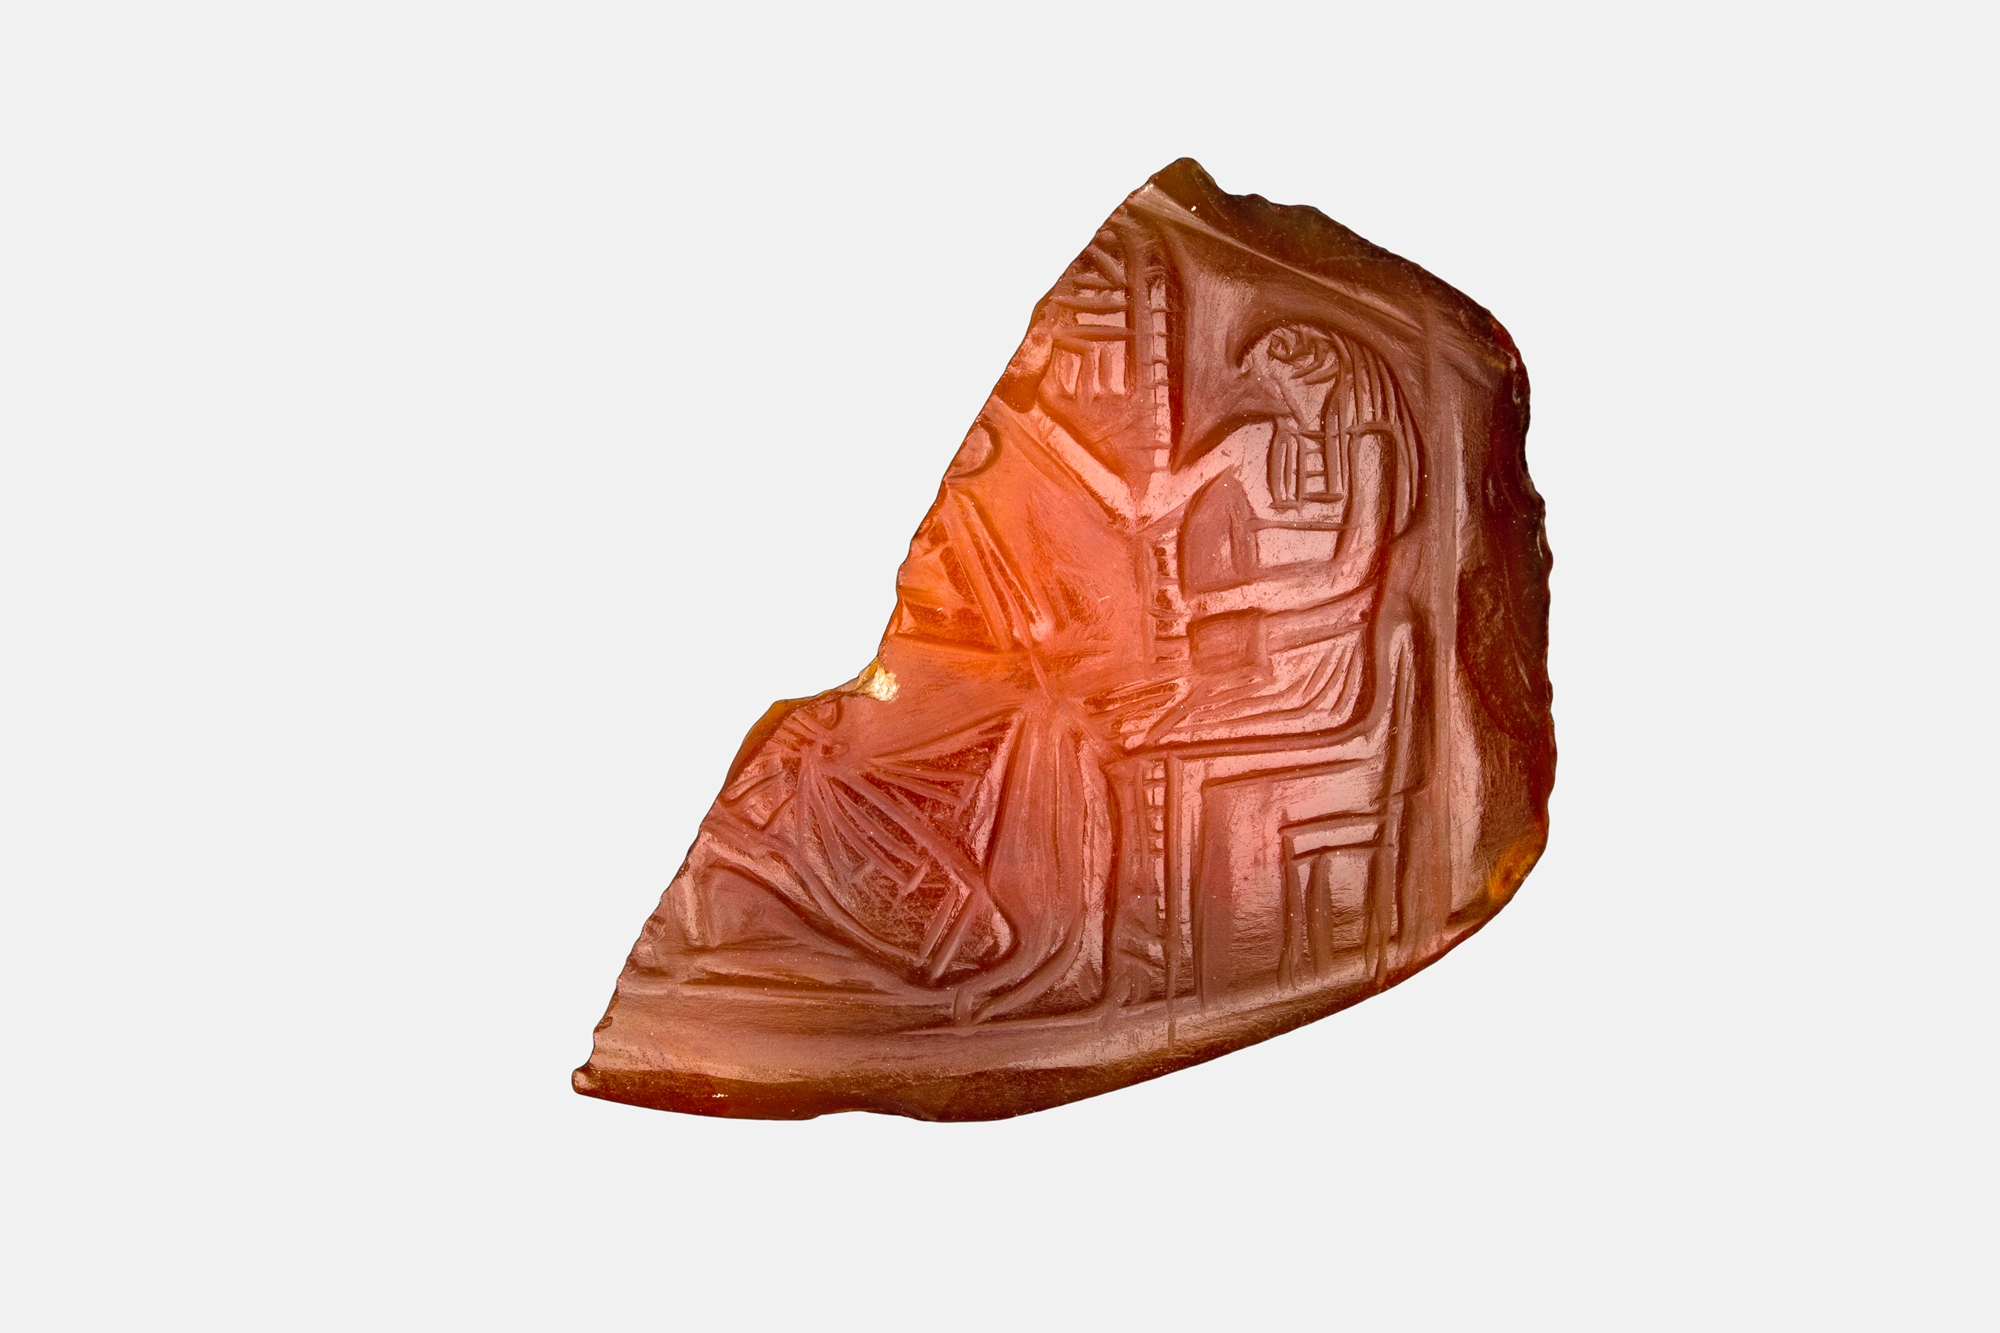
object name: plaque, jewelry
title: Plaque from a bracelet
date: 1390-1352 BCE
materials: gemstone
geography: egypt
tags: human figures